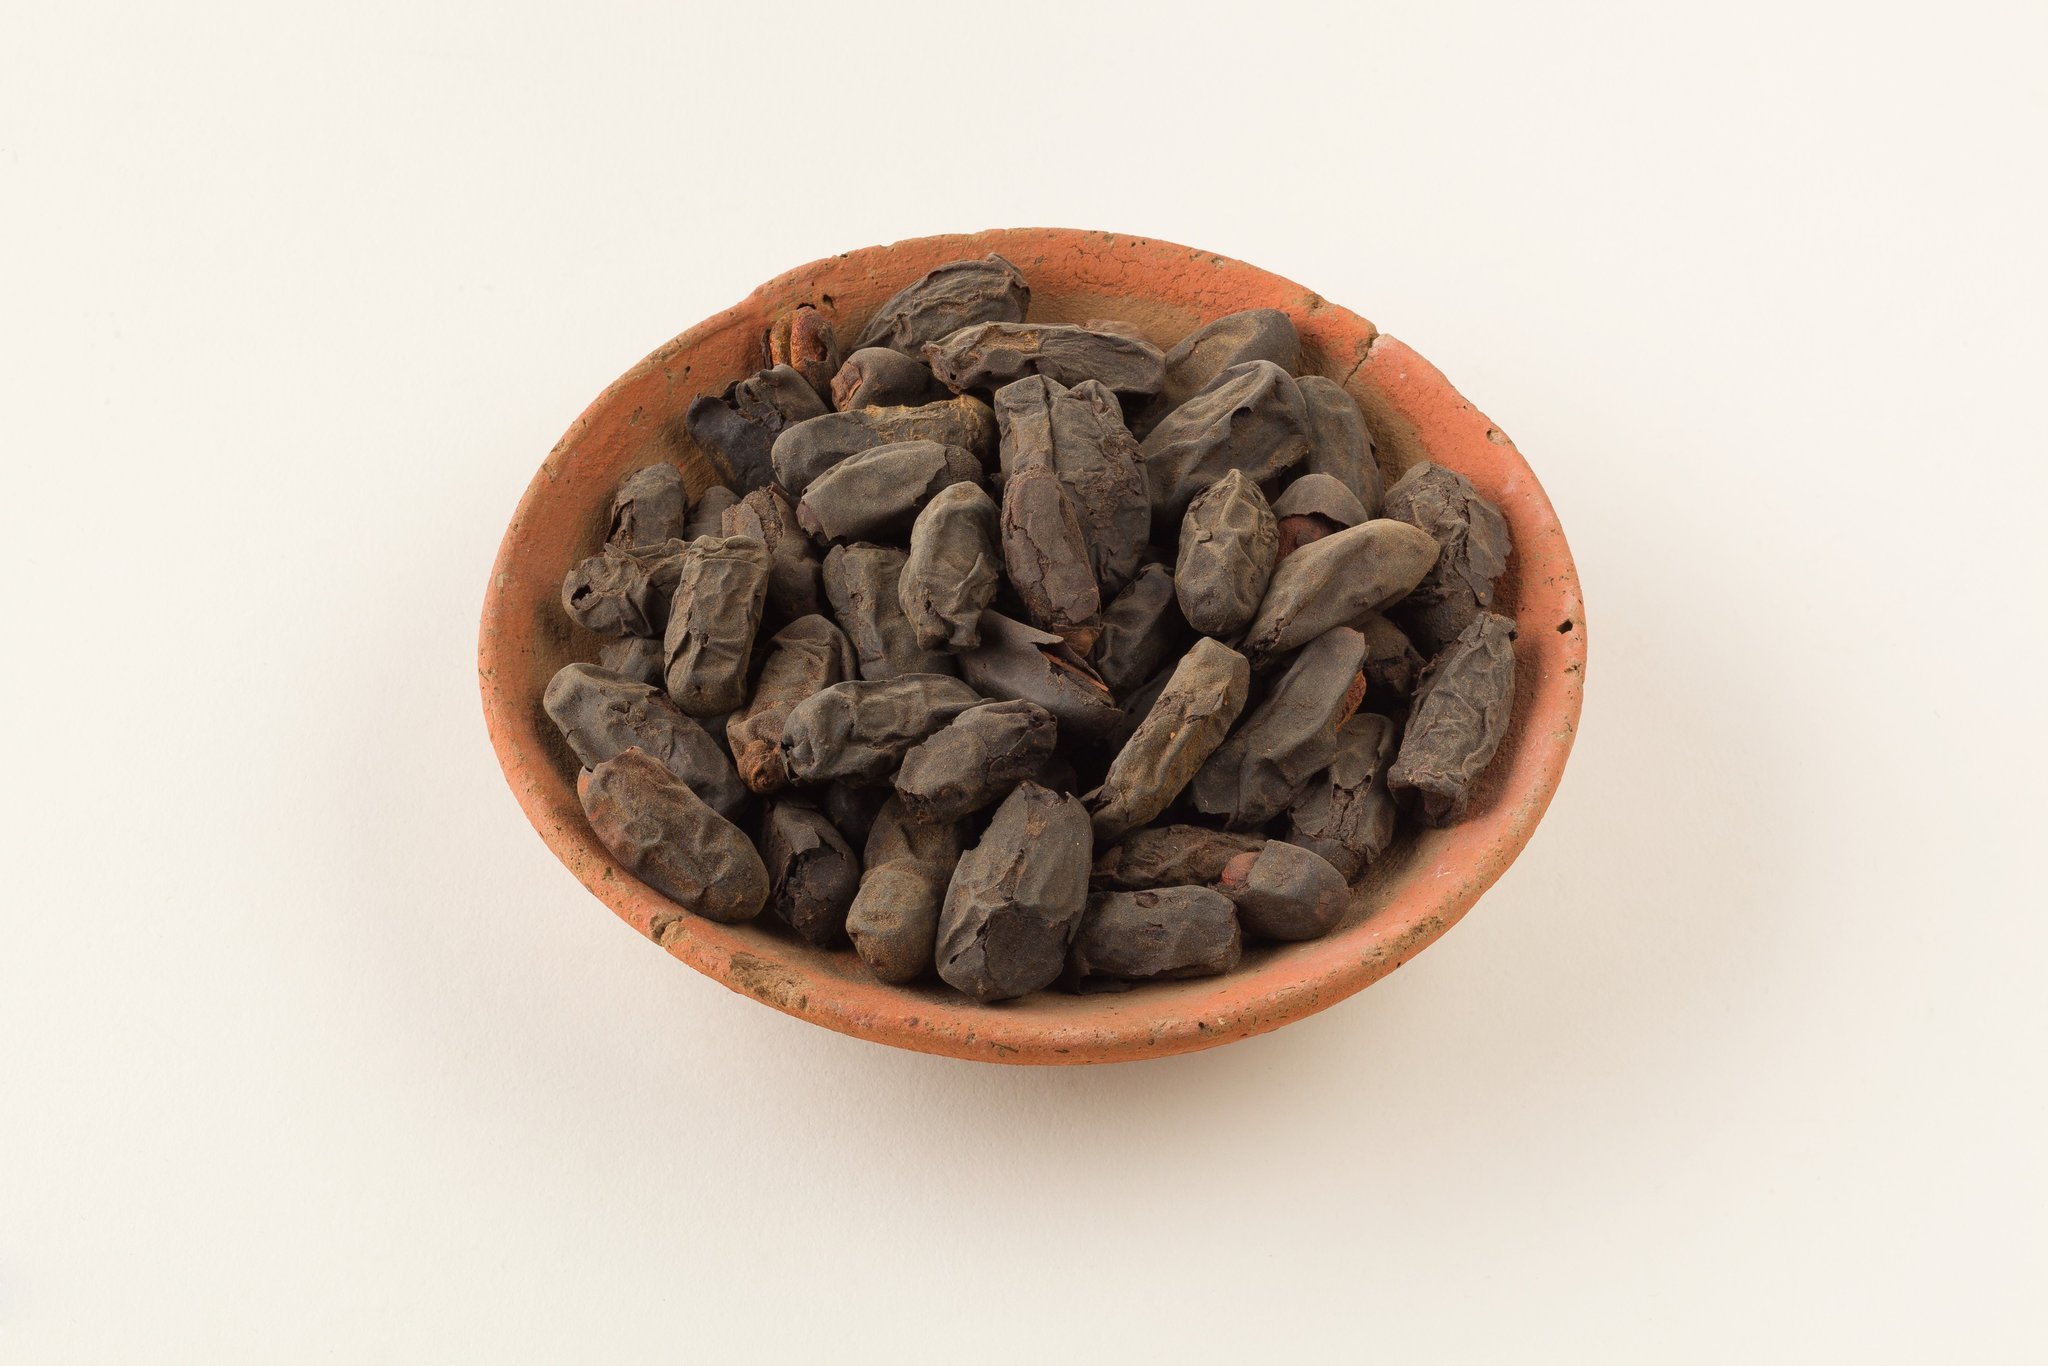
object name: dish, date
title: Dish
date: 1492-1473 BCE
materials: pottery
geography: egypt